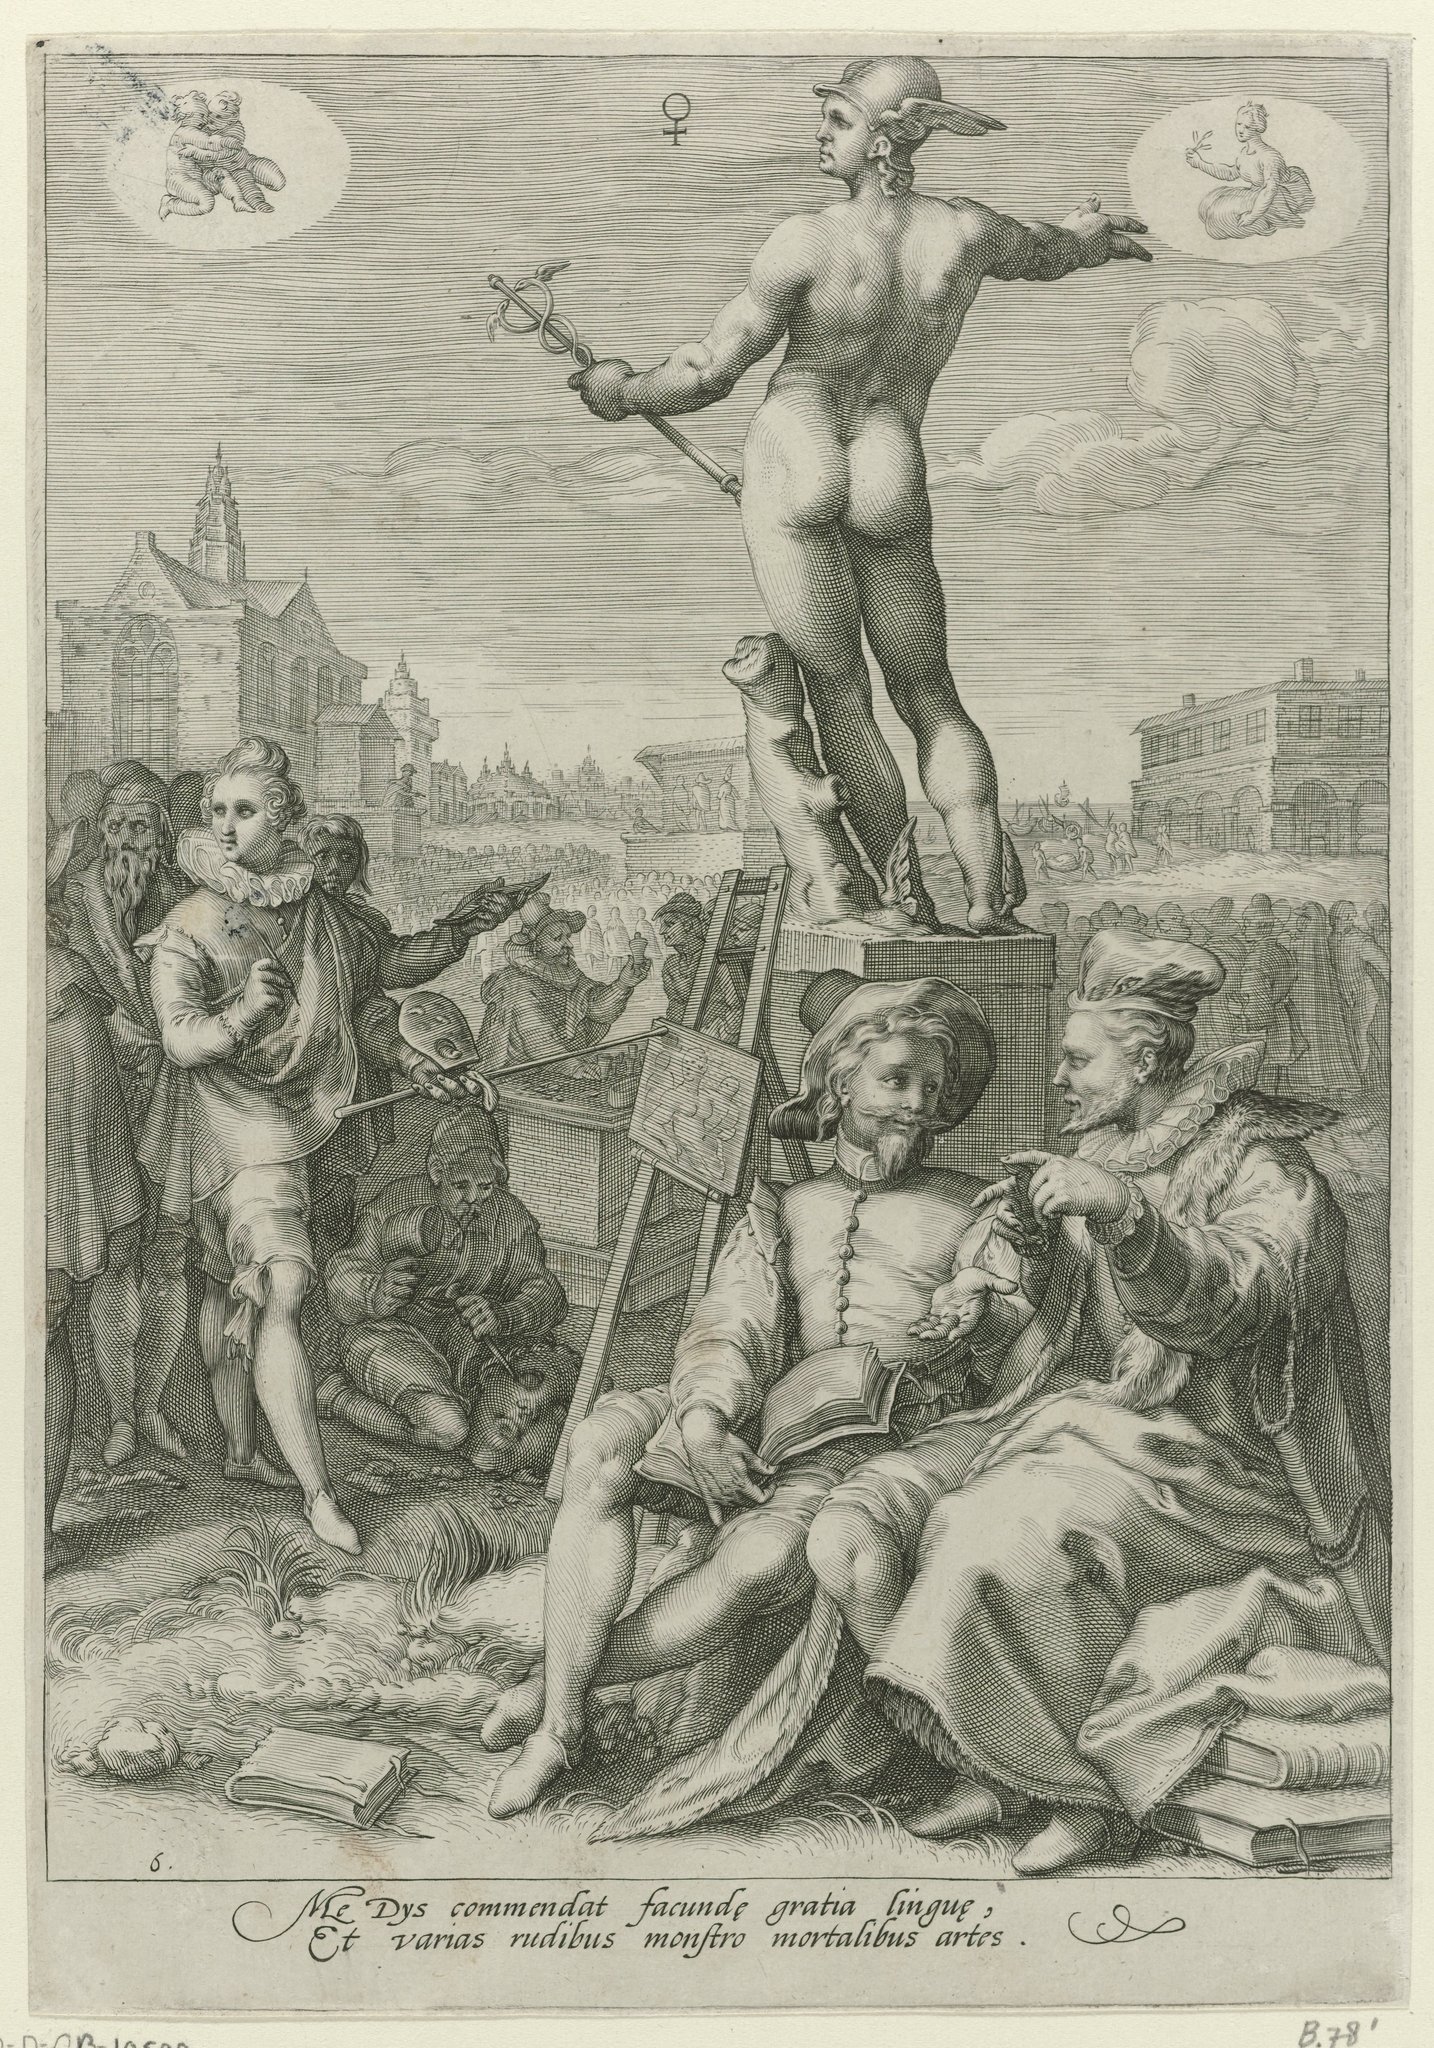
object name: print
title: Mercurius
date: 1596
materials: paper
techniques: engraving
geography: northern netherlands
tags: artist (in general) (+ artist at work), (story of) mercury (hermes), debate, discussion (~ meeting) - aa - in the open air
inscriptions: collector's mark: Lugt 240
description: Te midden van verschillende kunstenaars staat de naakte Mercurius als heerser over de kunsten op een sokkel. Op de voorgrond voeren twee schrijvers een discussie. In de lucht de symbolen van Mercurius (midden) en de sterrenbeelden tweelingen (links) en maagd (rechts).